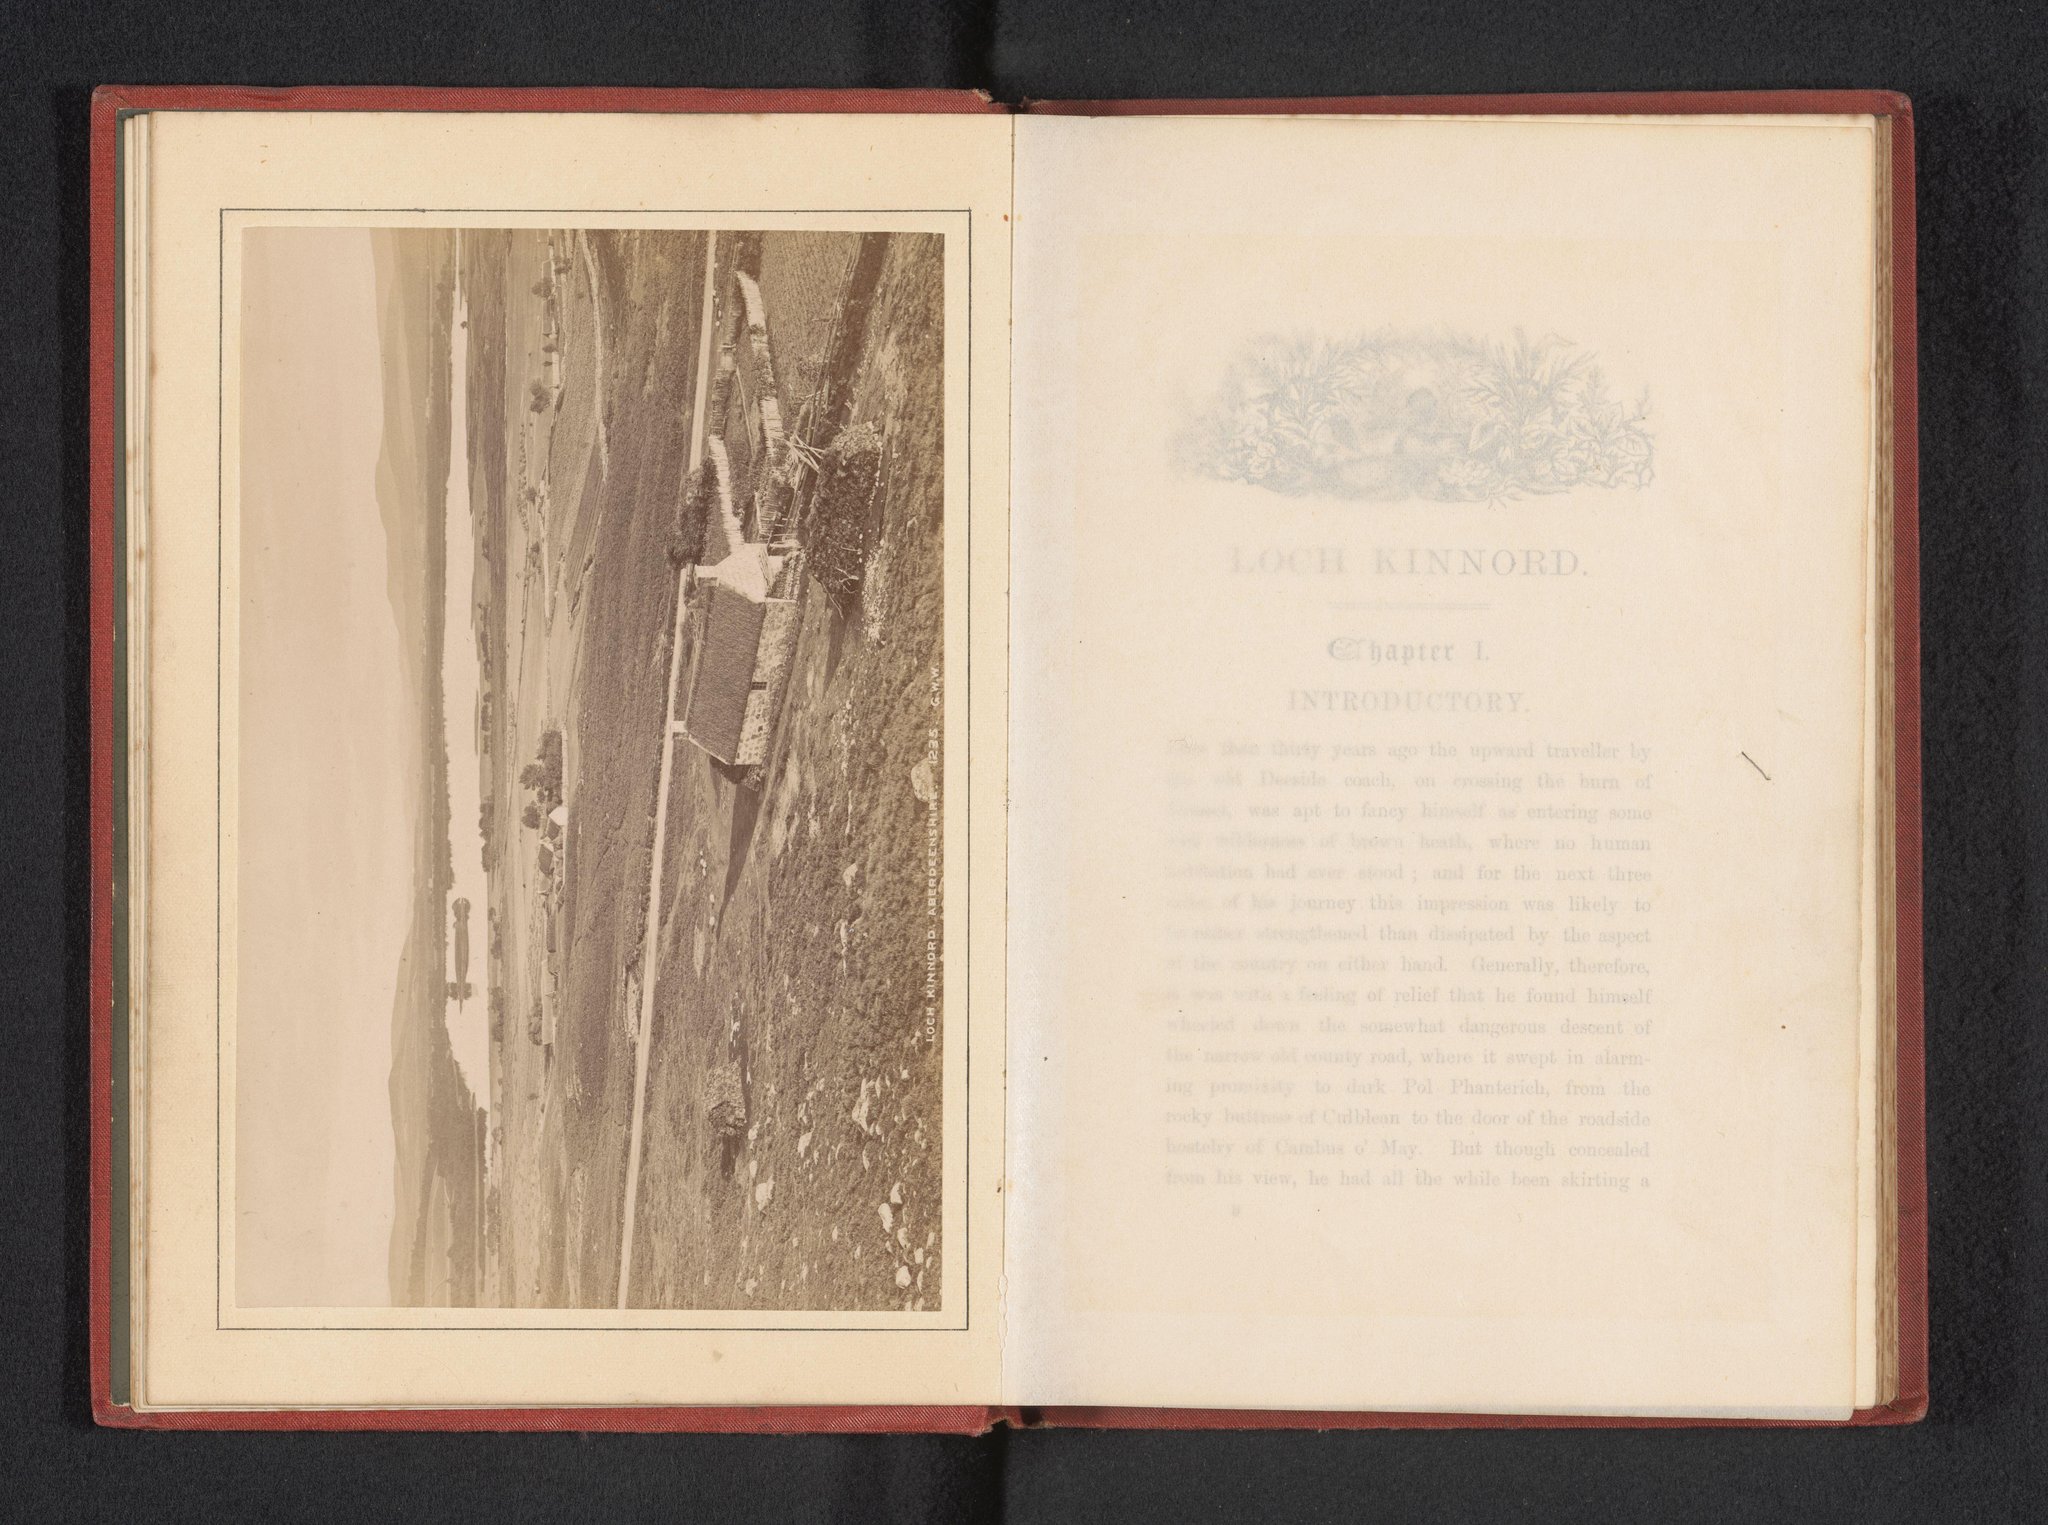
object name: page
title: Gezicht op Loch Kinord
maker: george washington wilson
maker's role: publisher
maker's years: 1823-1893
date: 1872-1877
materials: photographic support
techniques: albumen print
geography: aberdeenshire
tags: landscapes, lake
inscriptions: initials: ‘G.W.W.’, number: ‘1235’